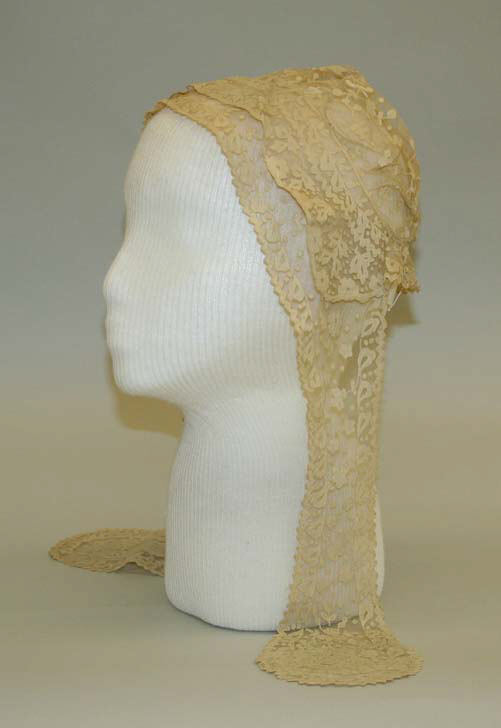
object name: cap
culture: american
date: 1850-1859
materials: cotton